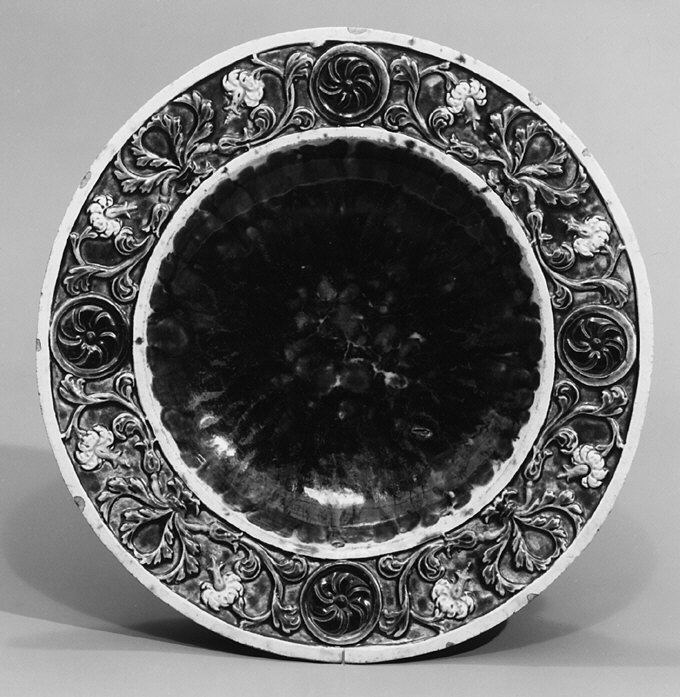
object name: plate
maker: bernard palissy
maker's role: maker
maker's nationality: french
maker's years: 1510-1590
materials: earthenware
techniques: glazing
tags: flowers